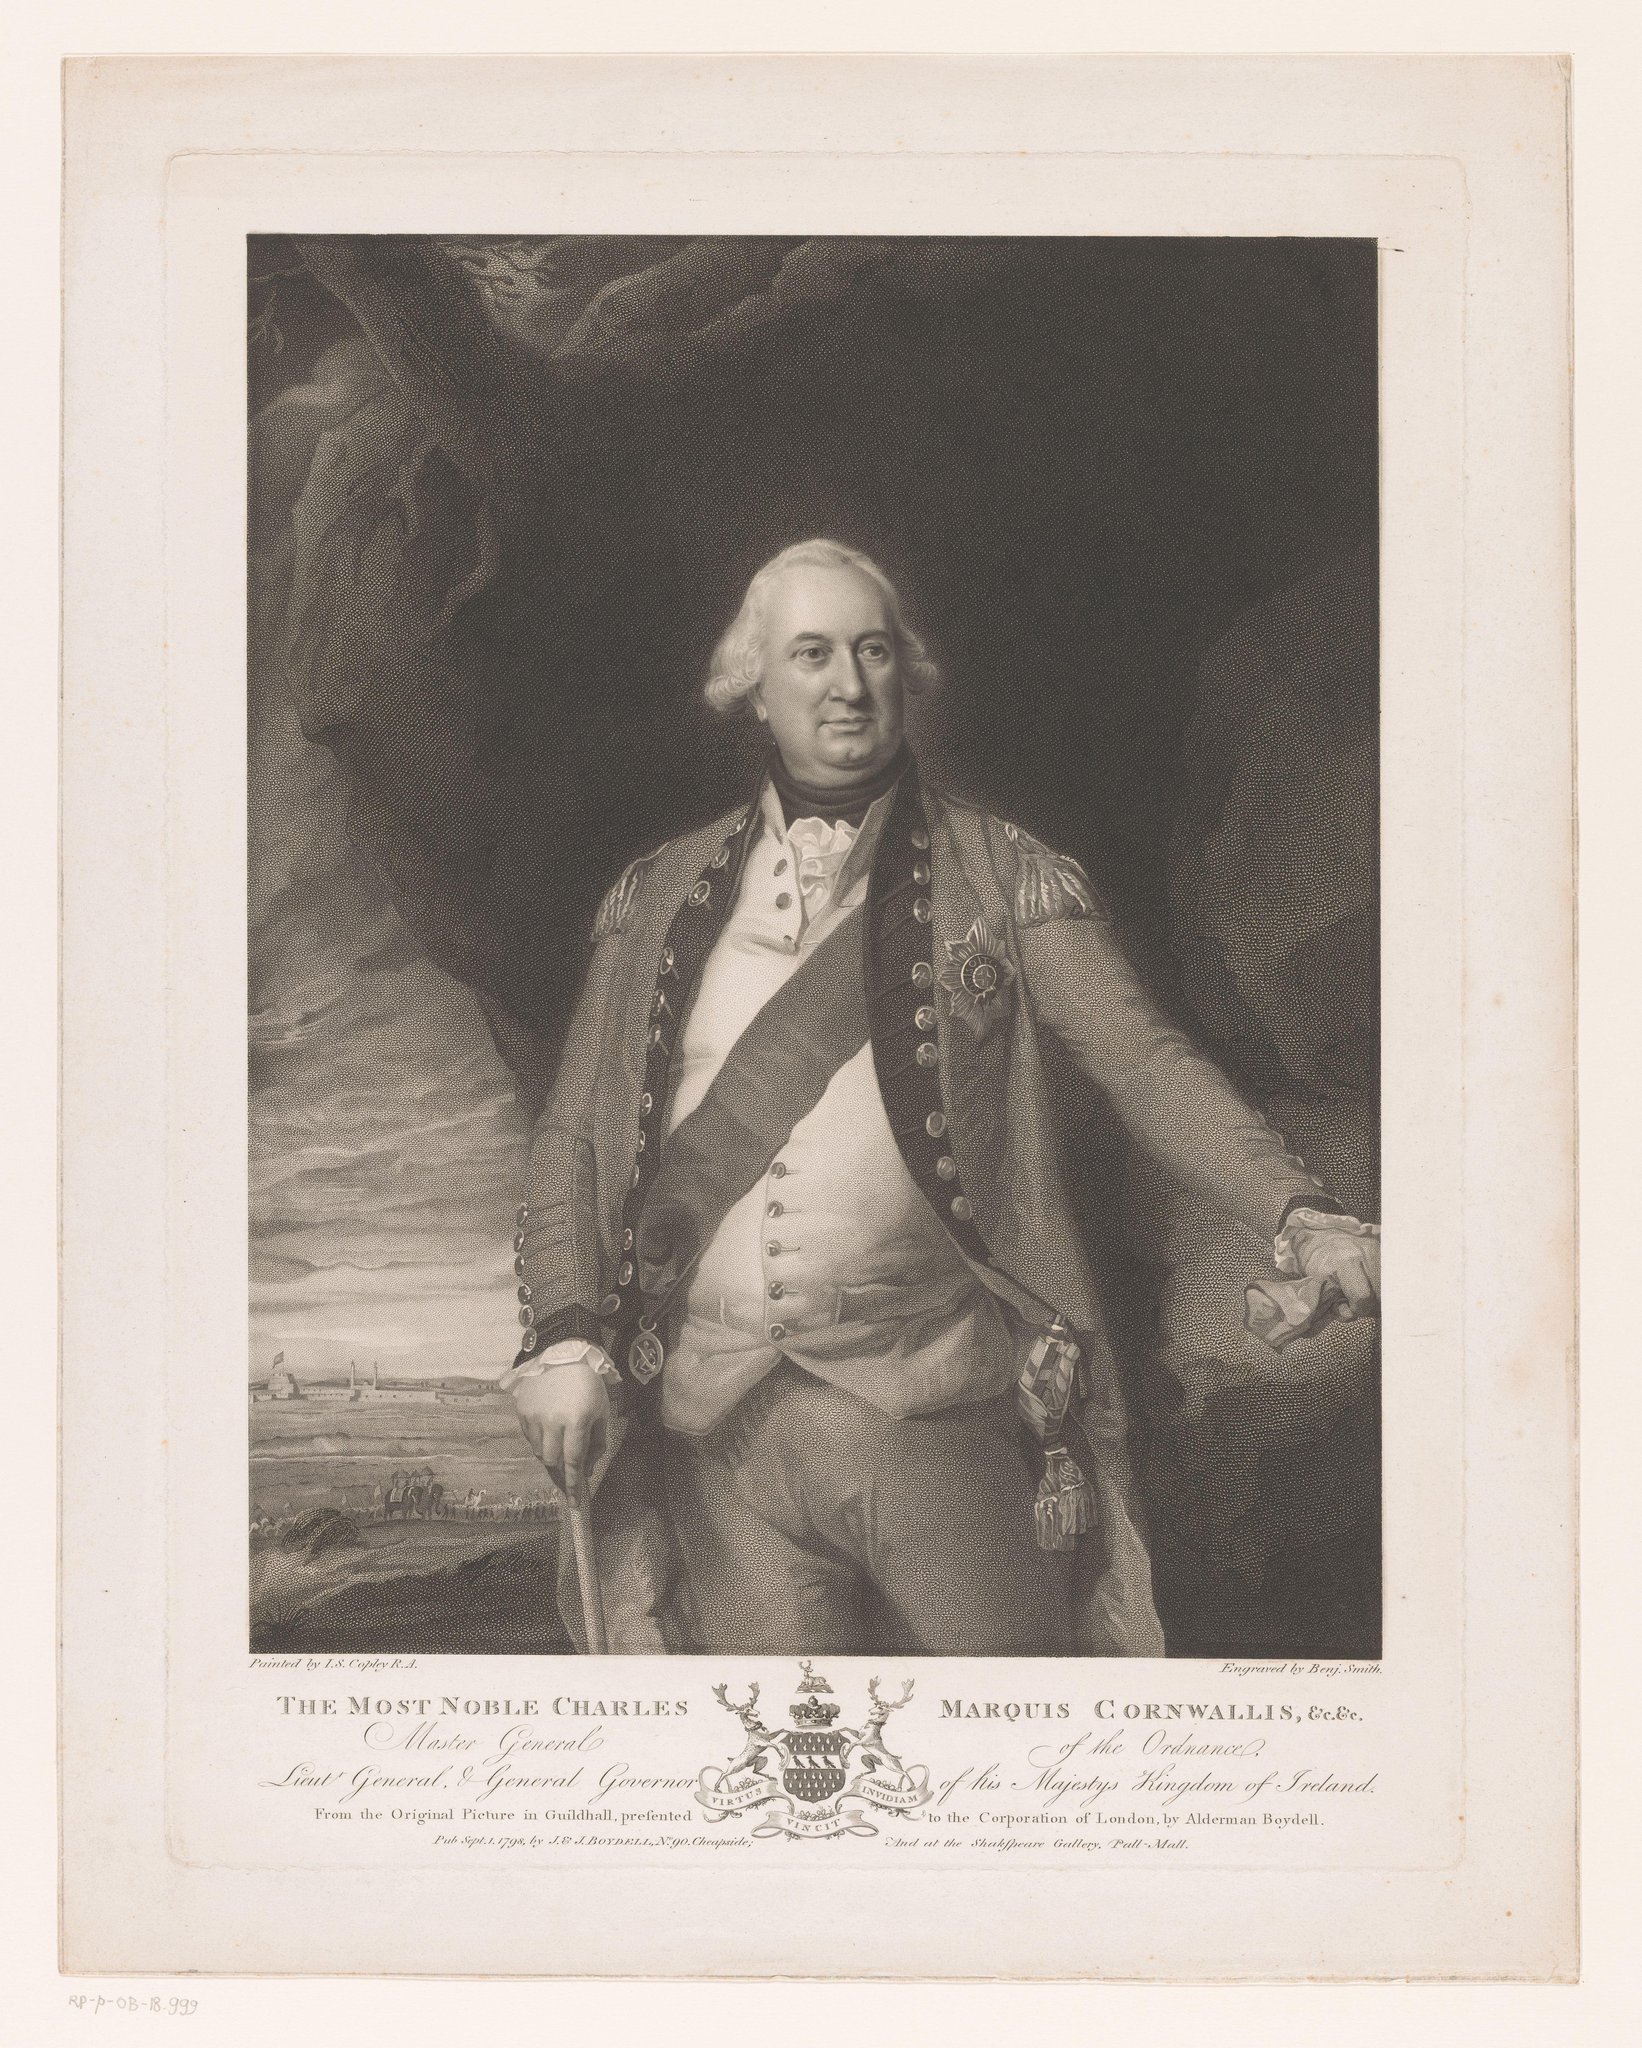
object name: print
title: Portret van Charles Cornwallis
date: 1798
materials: paper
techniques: engraving, etching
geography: london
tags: politician, historical persons, commander-in-chief, admiral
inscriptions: collector's mark: Lugt 2228